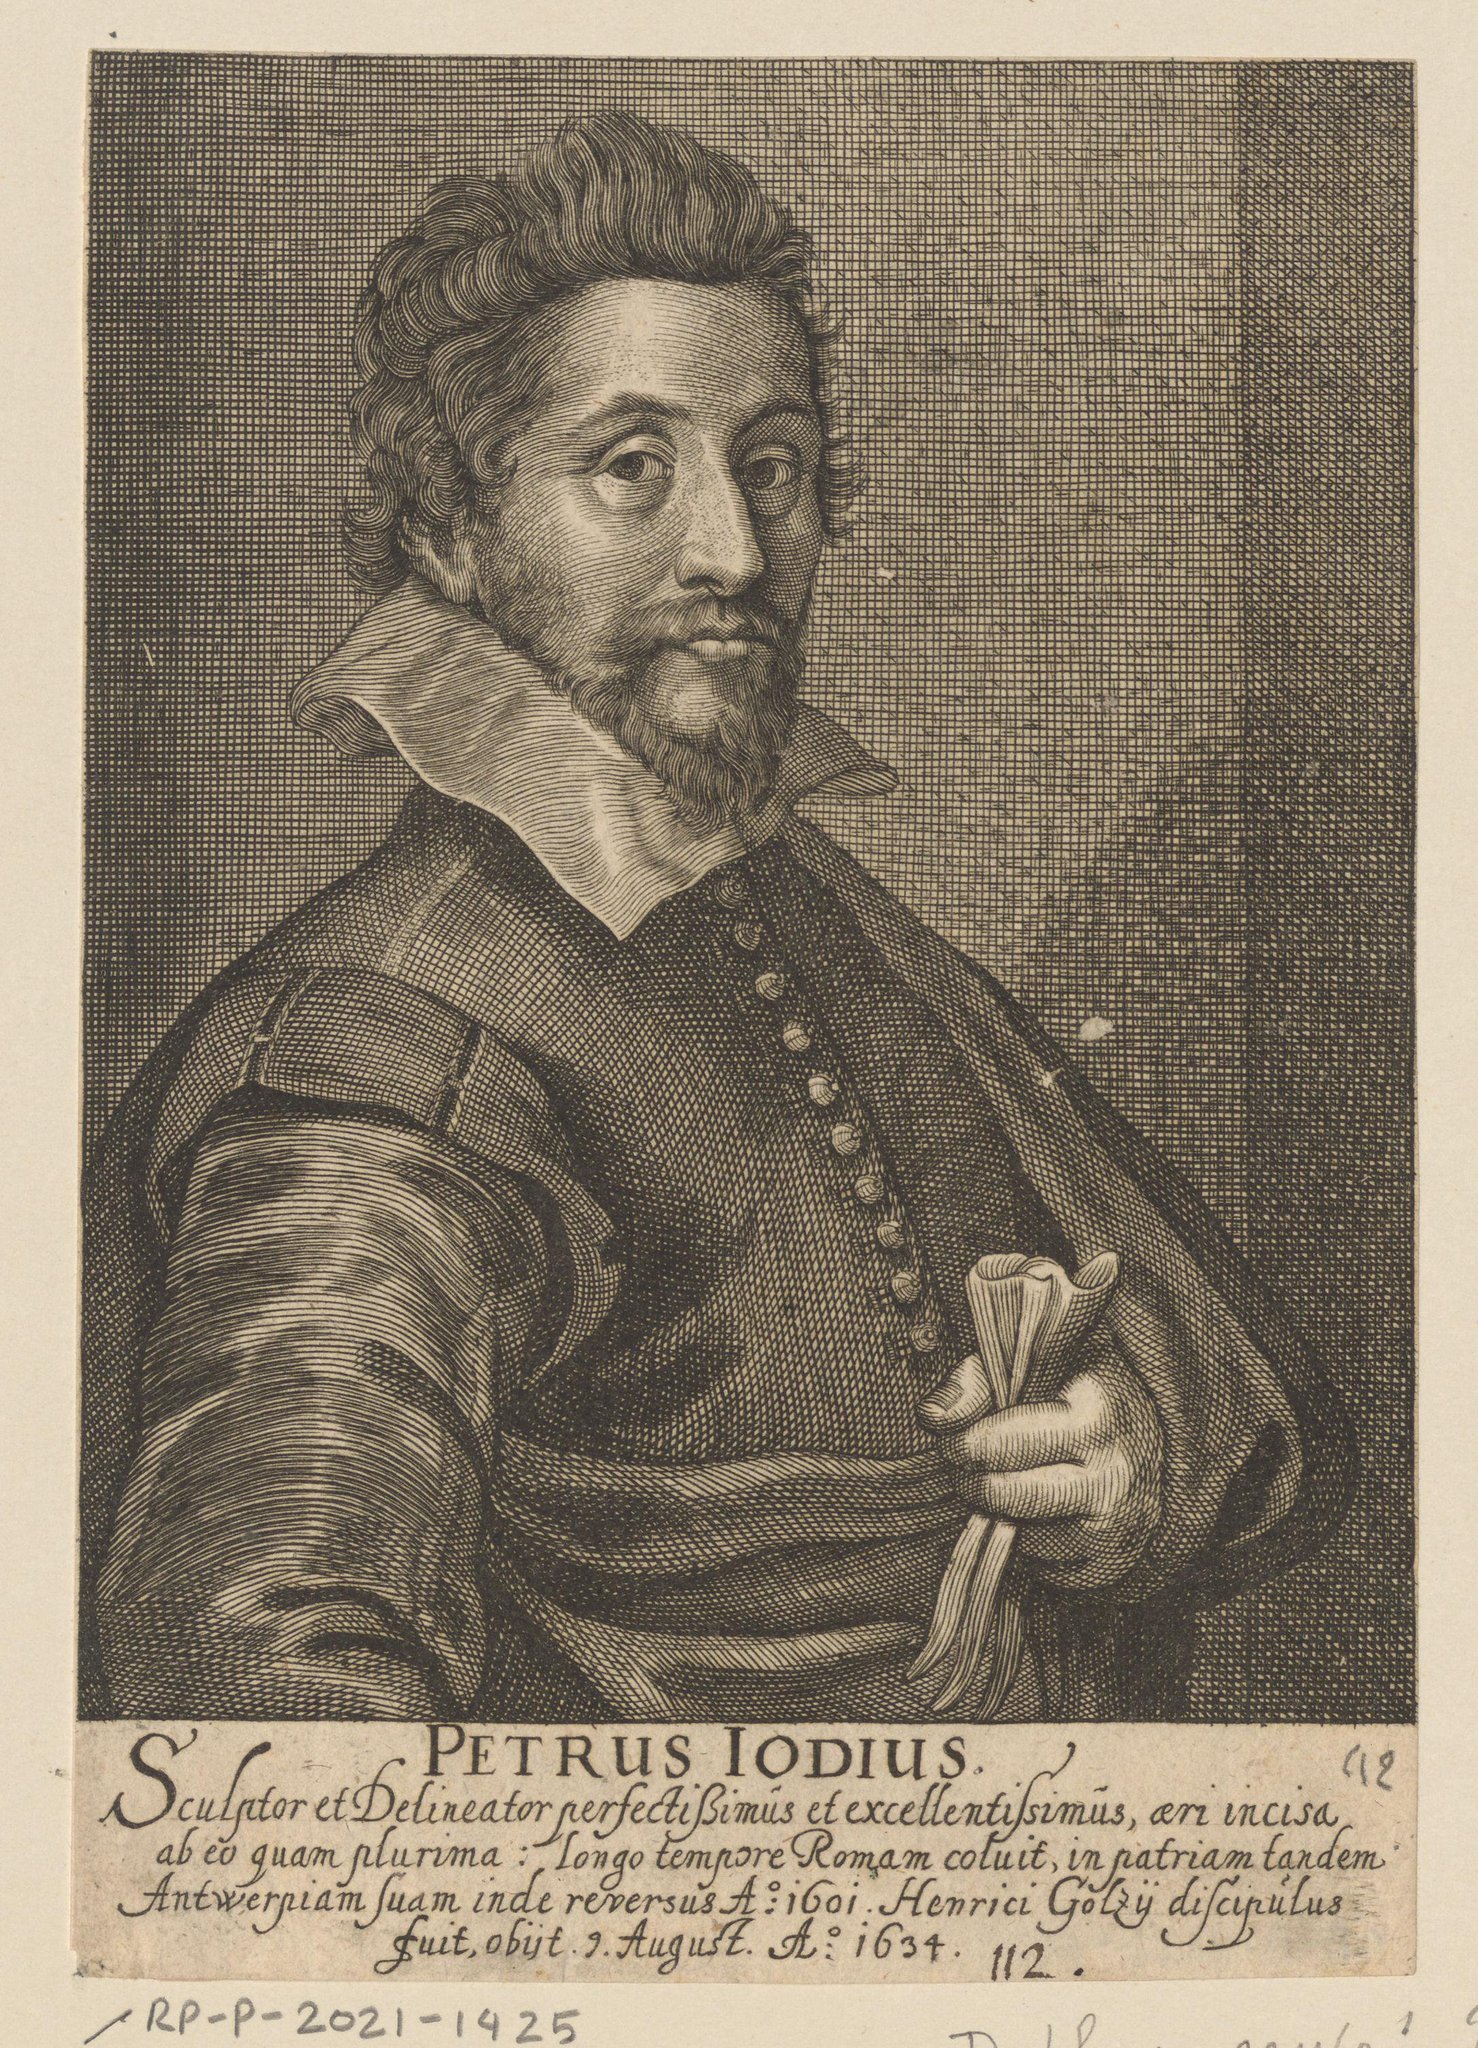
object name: print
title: Portret van Pieter de Jode I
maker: Anonymous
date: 1634-1699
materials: paper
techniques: engraving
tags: antwerp, historical persons, portrait, self-portrait of graphic artist